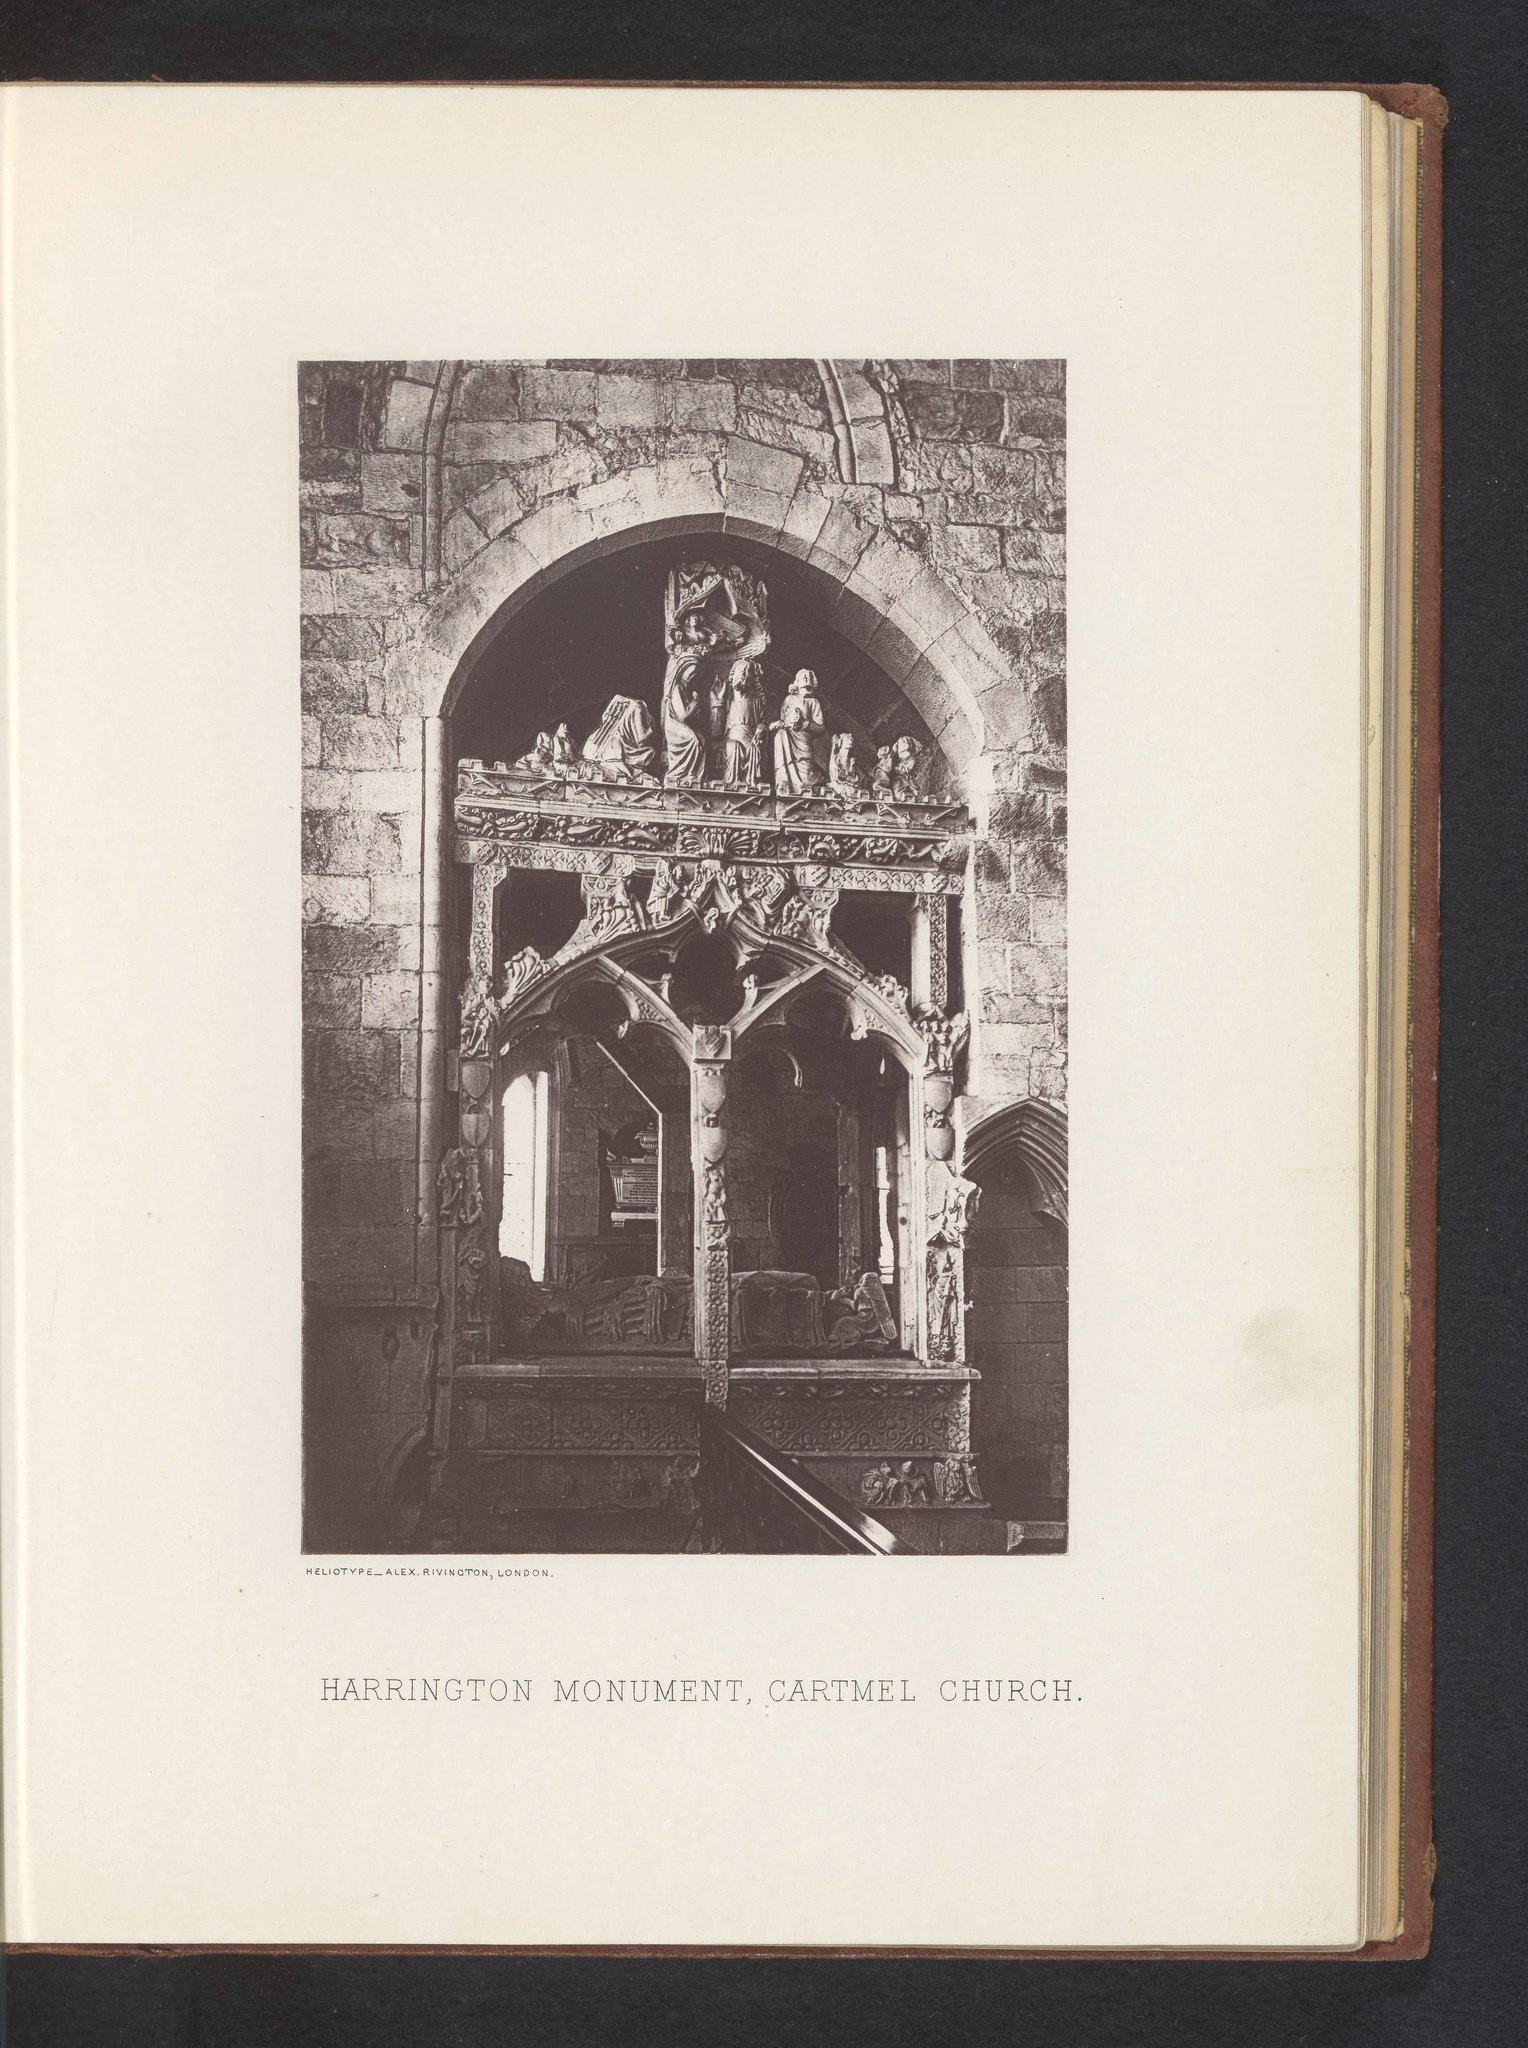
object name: page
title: Harringtonmonument in de Cartmel Priory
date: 1870-1880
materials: paper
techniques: heliotype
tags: interior of church, monument, statue